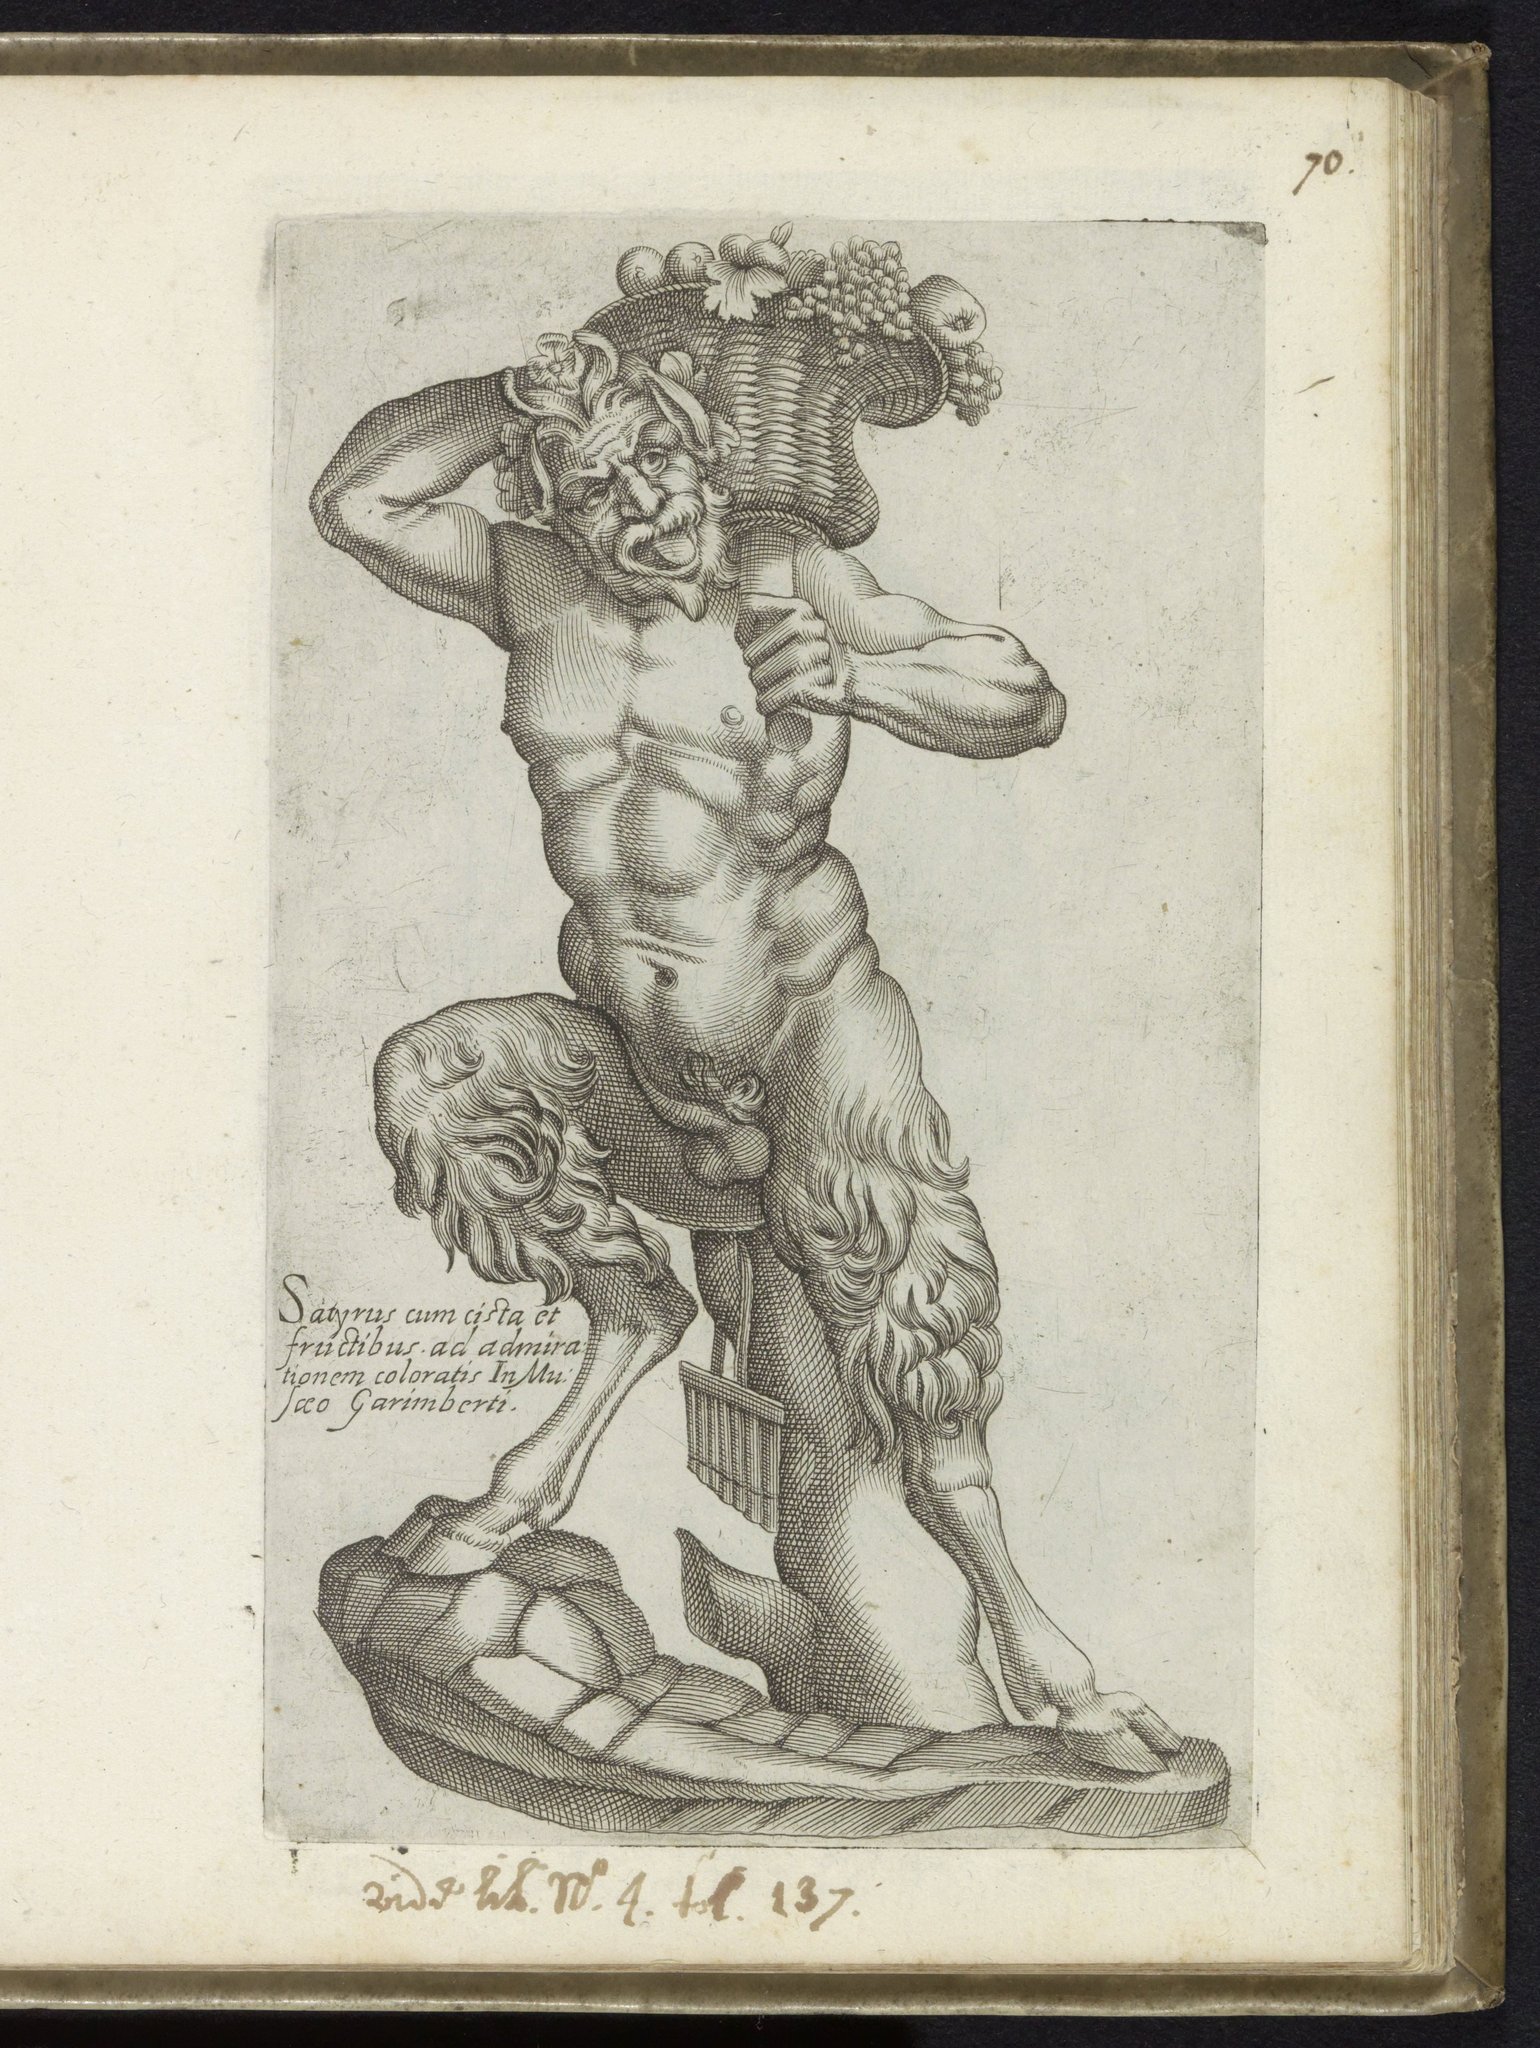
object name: album leaf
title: Sculpturen uit de oudheid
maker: Anonymous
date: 1600-1699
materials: paper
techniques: engraving, etching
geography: italy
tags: piece of sculpture, reproduction of a piece of sculpture, satyr(s) (in general)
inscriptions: inscription: ‘Ende lib. No. 21. fol. 339. Ende lib. No. 23. fol. 79.’, number: ‘70’, inscription: ‘Ende lib. No. 4. fol. 137.’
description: Deze prent maakt deel uit van een reeks van ten minste 50 prenten van sculpturen uit de oudheid.